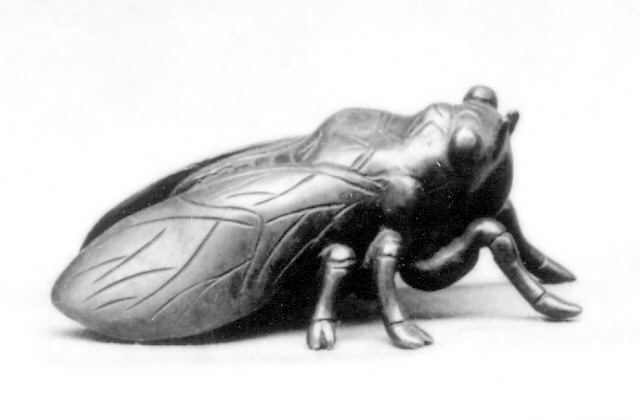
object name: ornament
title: Ornament in the Form of a Bee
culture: japanese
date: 1801-1900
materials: bronze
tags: bees